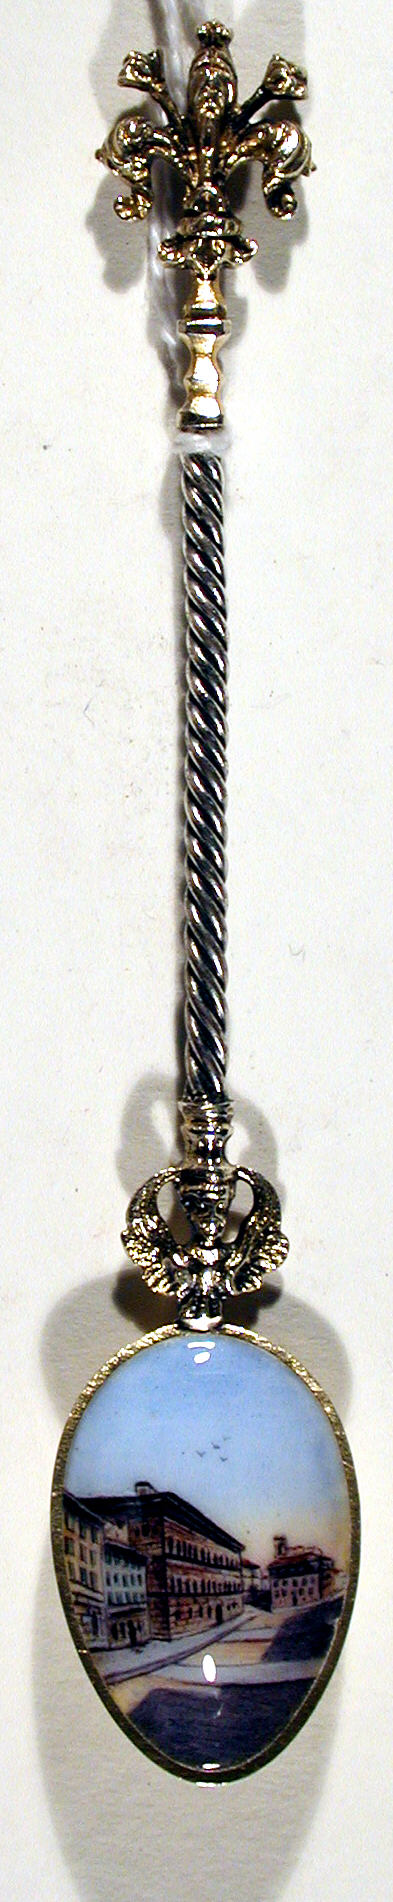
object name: souvenir spoon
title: Souvenir spoon with view of Medici Palace, Florence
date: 1867-1900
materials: enamel, gilt, silver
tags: palaces